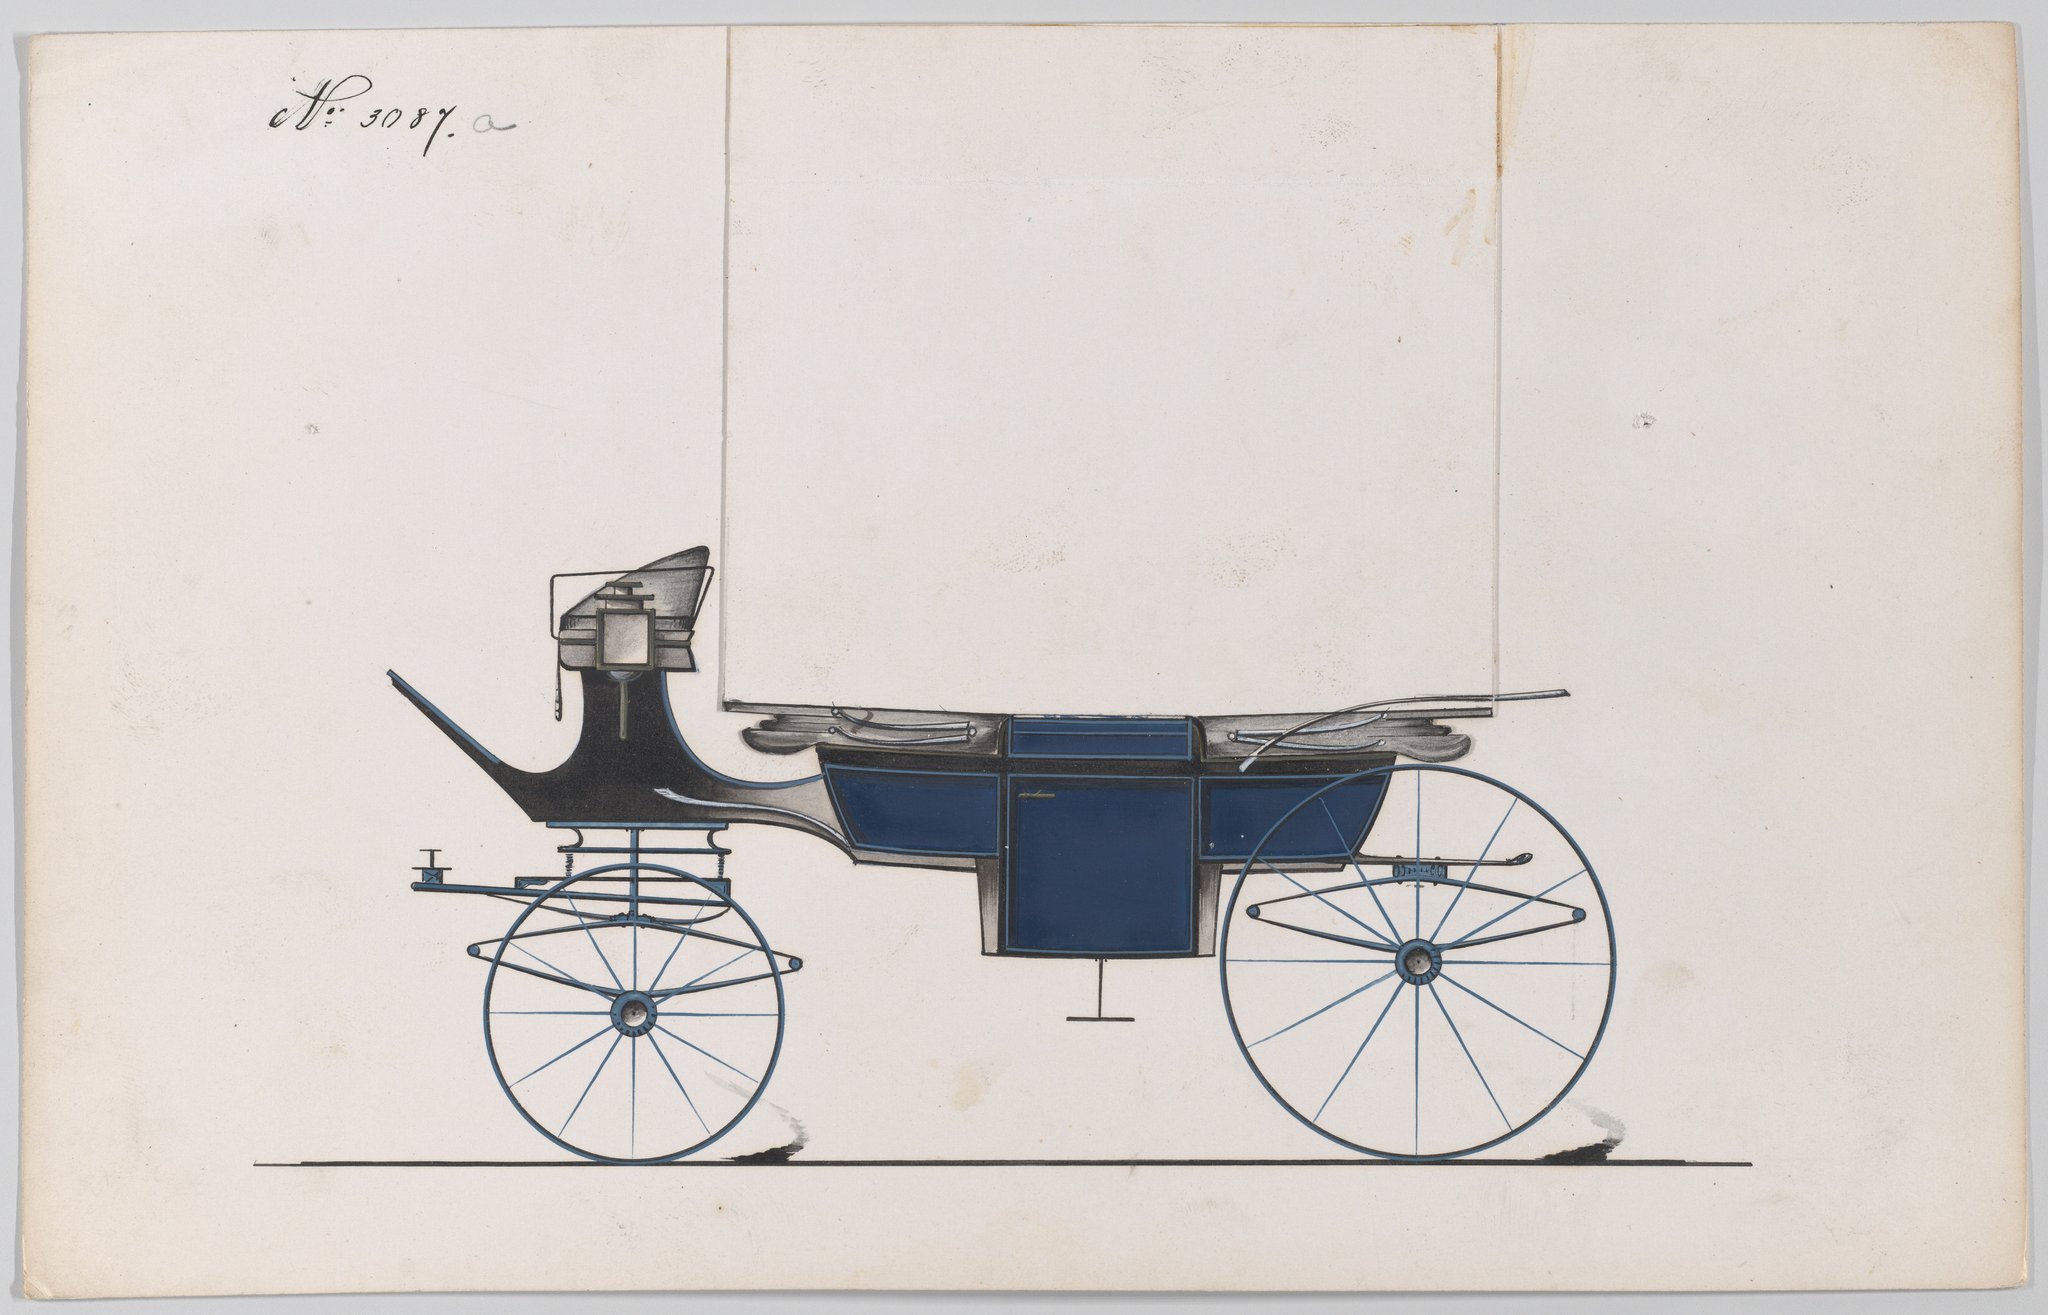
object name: drawing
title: Design for Landau, No. 3087a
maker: brewster & co.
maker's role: manufacturer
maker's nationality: american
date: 1875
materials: gouache, gum arabic, ink, watercolor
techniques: pen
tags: carriages